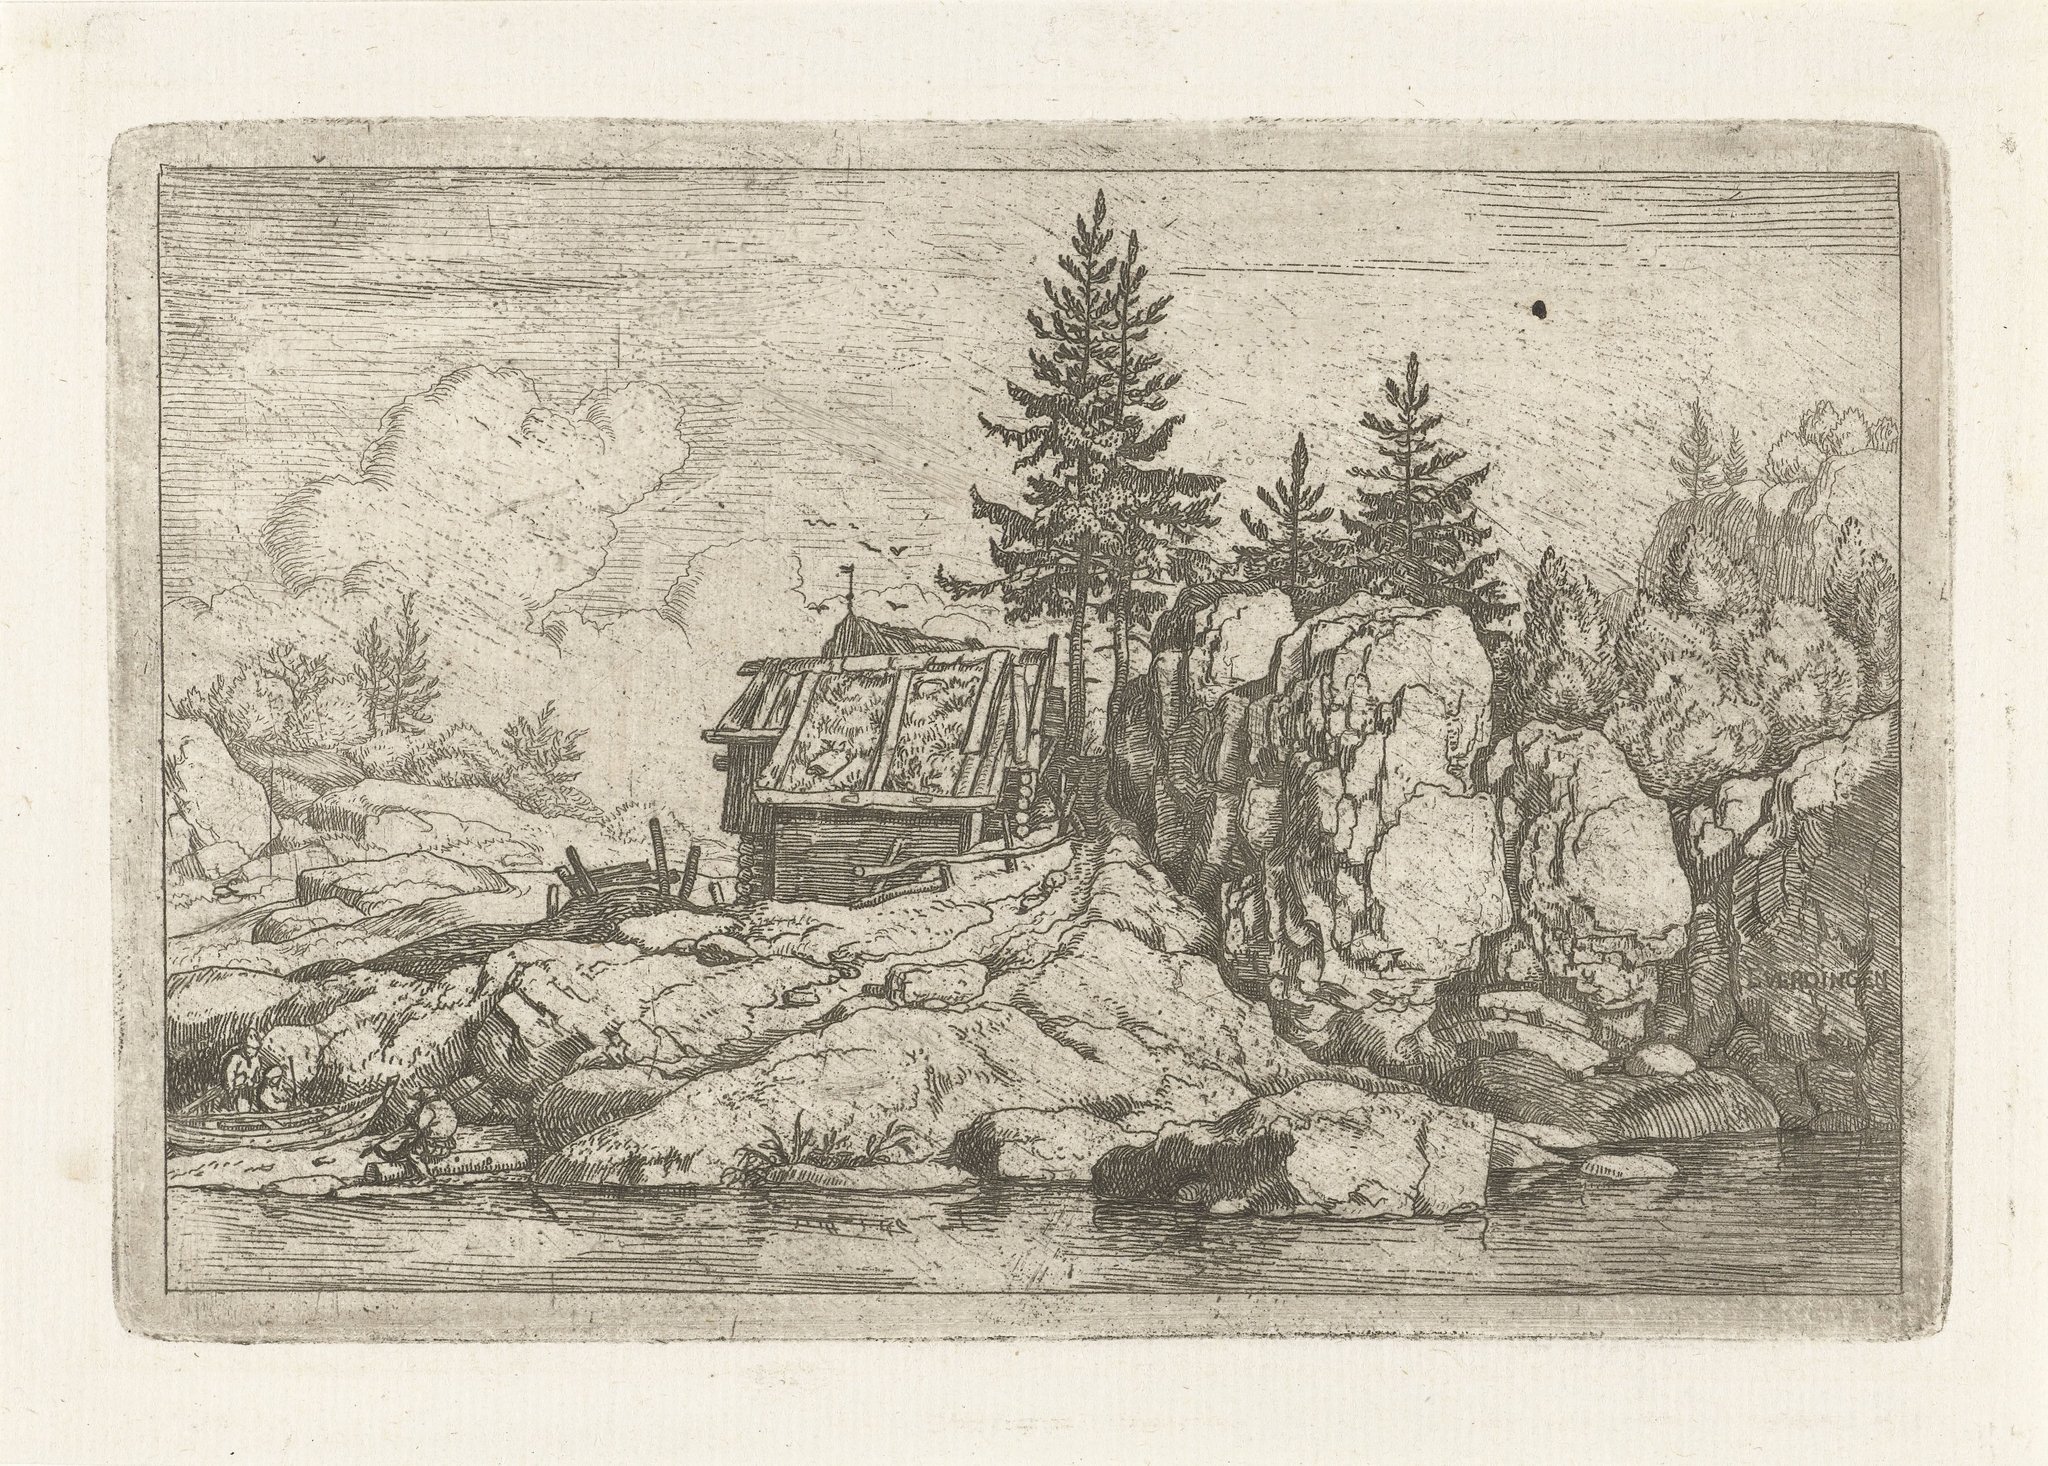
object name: print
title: Landschap met vier sparren bij hut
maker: allaert van everdingen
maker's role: draughtsman, painter, print maker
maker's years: 1621-1675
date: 1631-1675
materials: paper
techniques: etching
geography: netherlands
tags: farm or solitary house in landscape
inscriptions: collector's mark: Lugt 2228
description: Rotslandschap met vier sparren naast een houten hut met rieten dak. Op de oever op de voorgrond drie personen en een roeiboot.